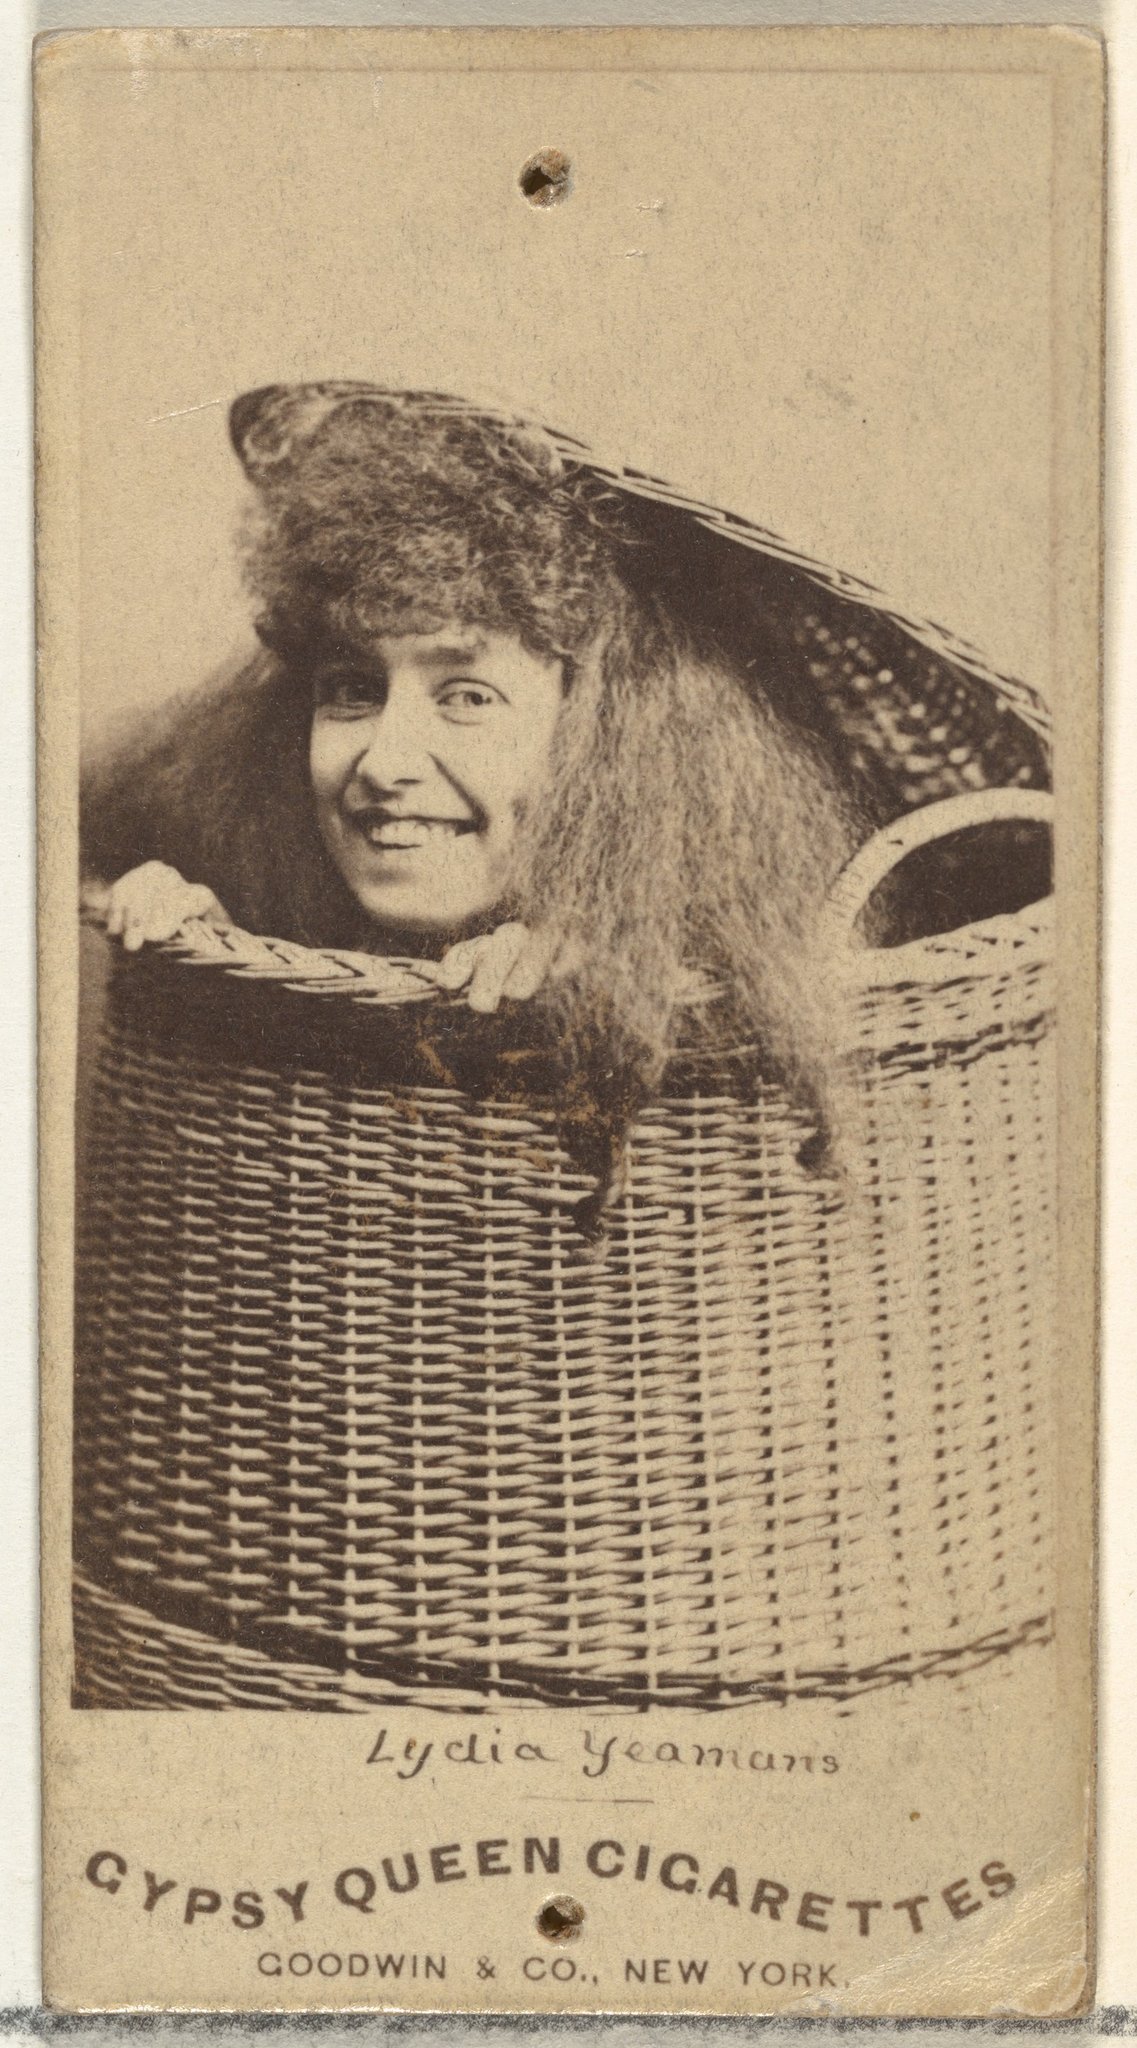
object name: photograph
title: Lydia Yeamans, from the Actors and Actresses series (N171) for Gypsy Queen Cigarettes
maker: goodwin & company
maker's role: publisher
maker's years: 1850-1950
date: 1886-1890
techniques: albumen silver print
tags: portraits,women,actresses